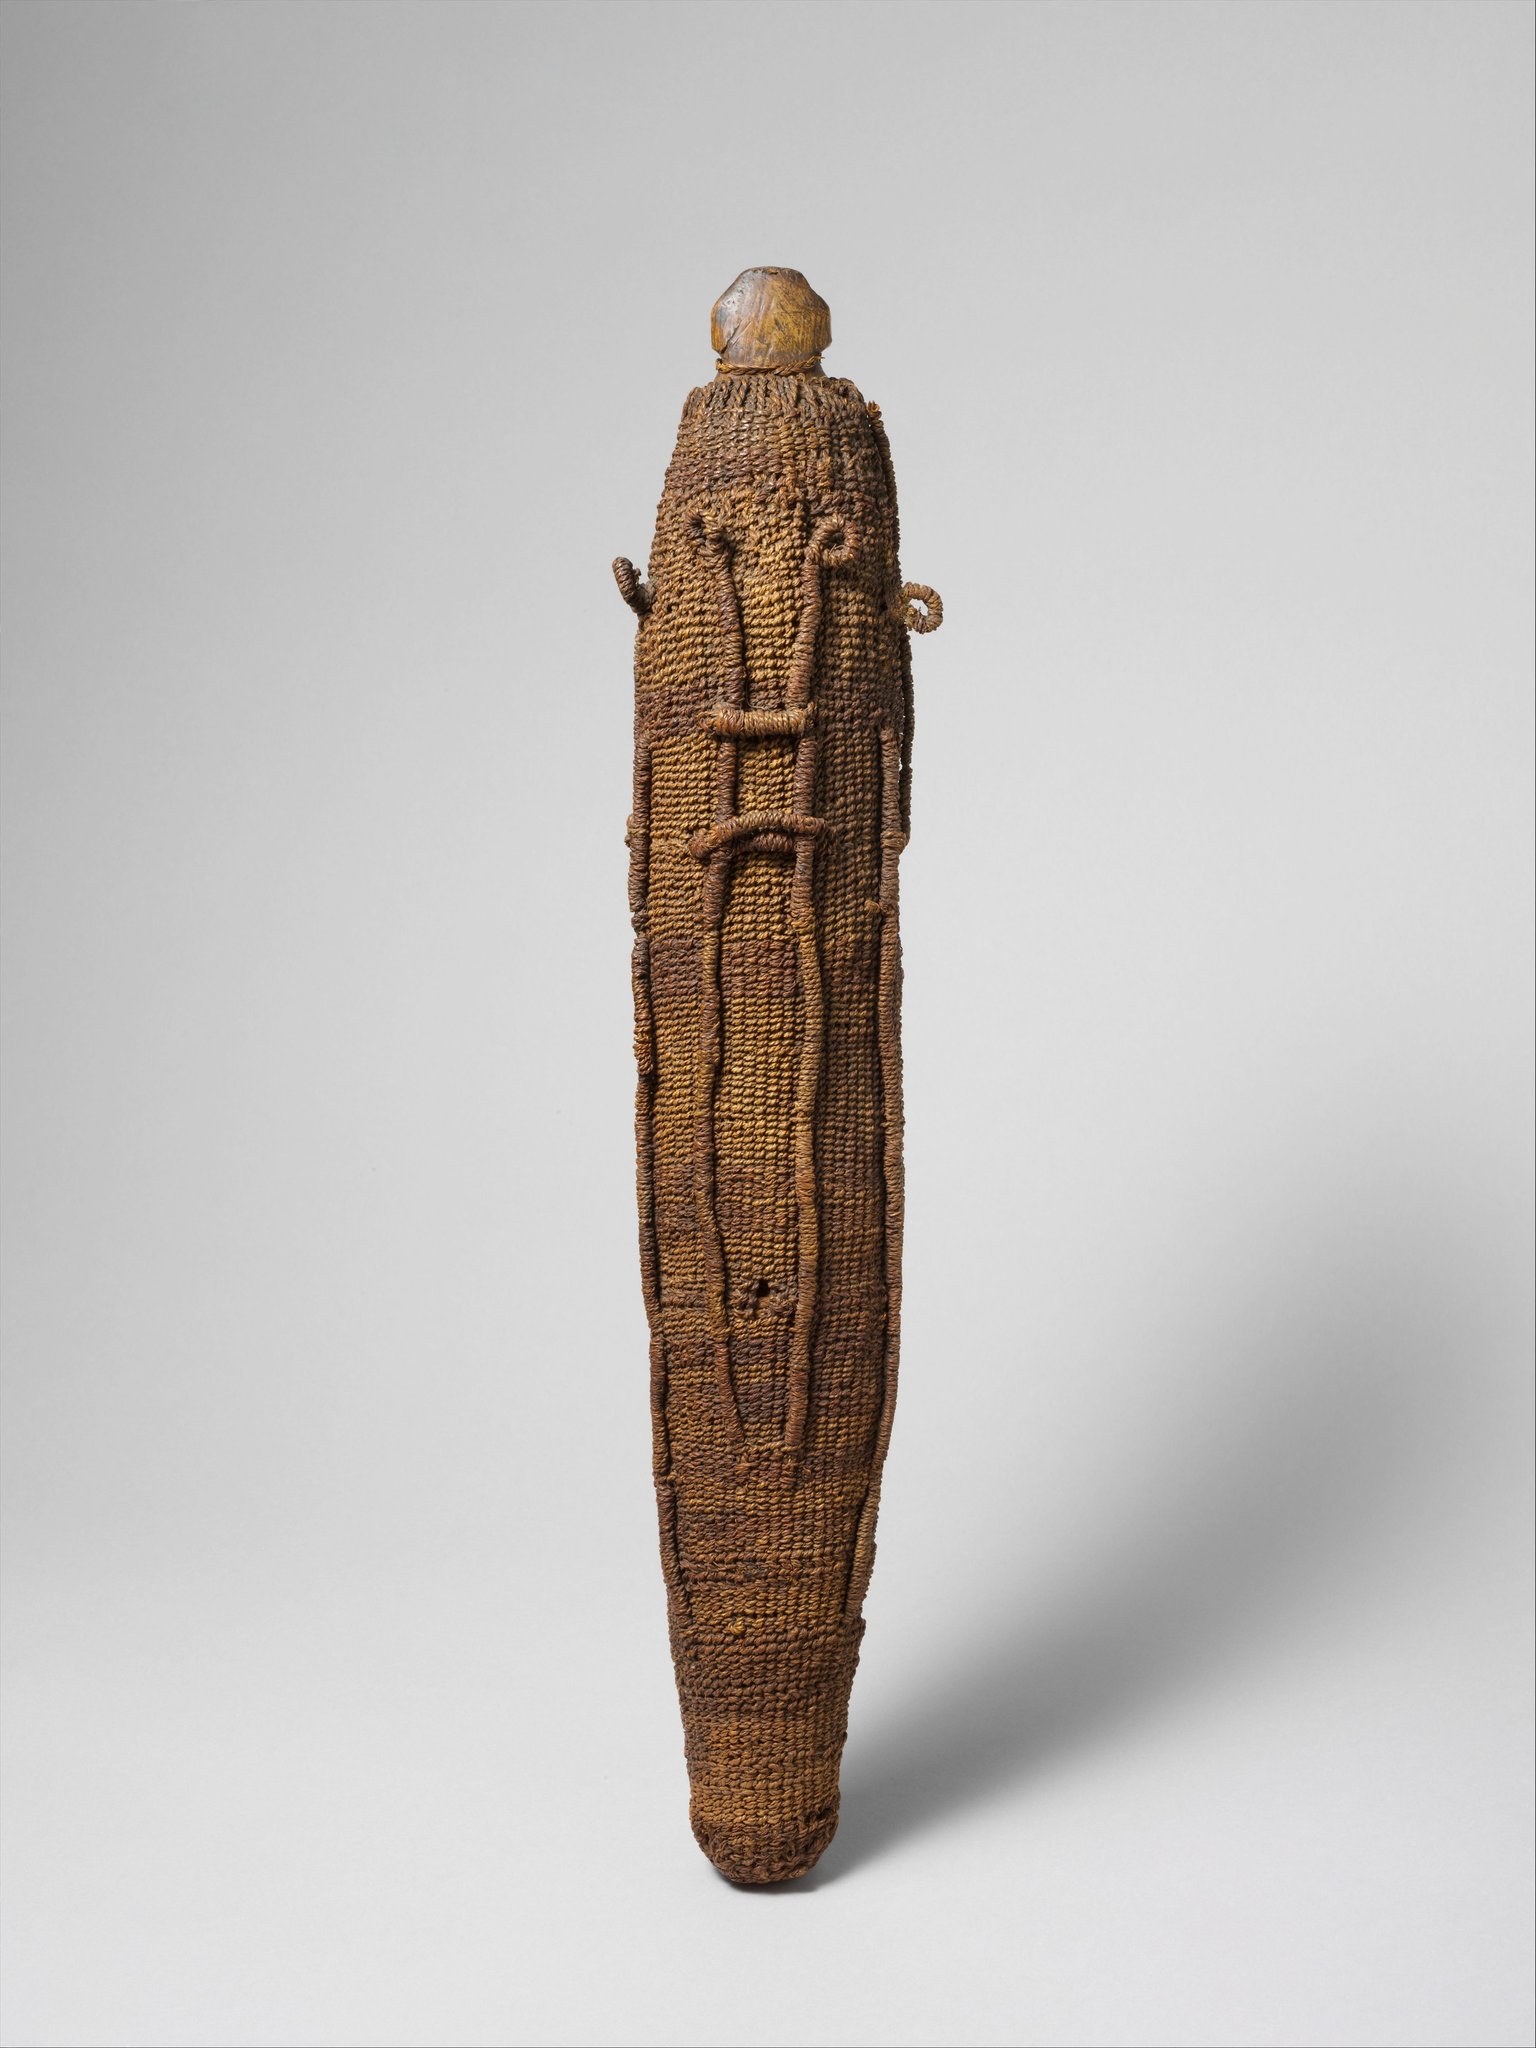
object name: figure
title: Ritual image (to'o) representing the deity Oro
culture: maohi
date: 1701-1800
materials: fiber, wood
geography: tahiti